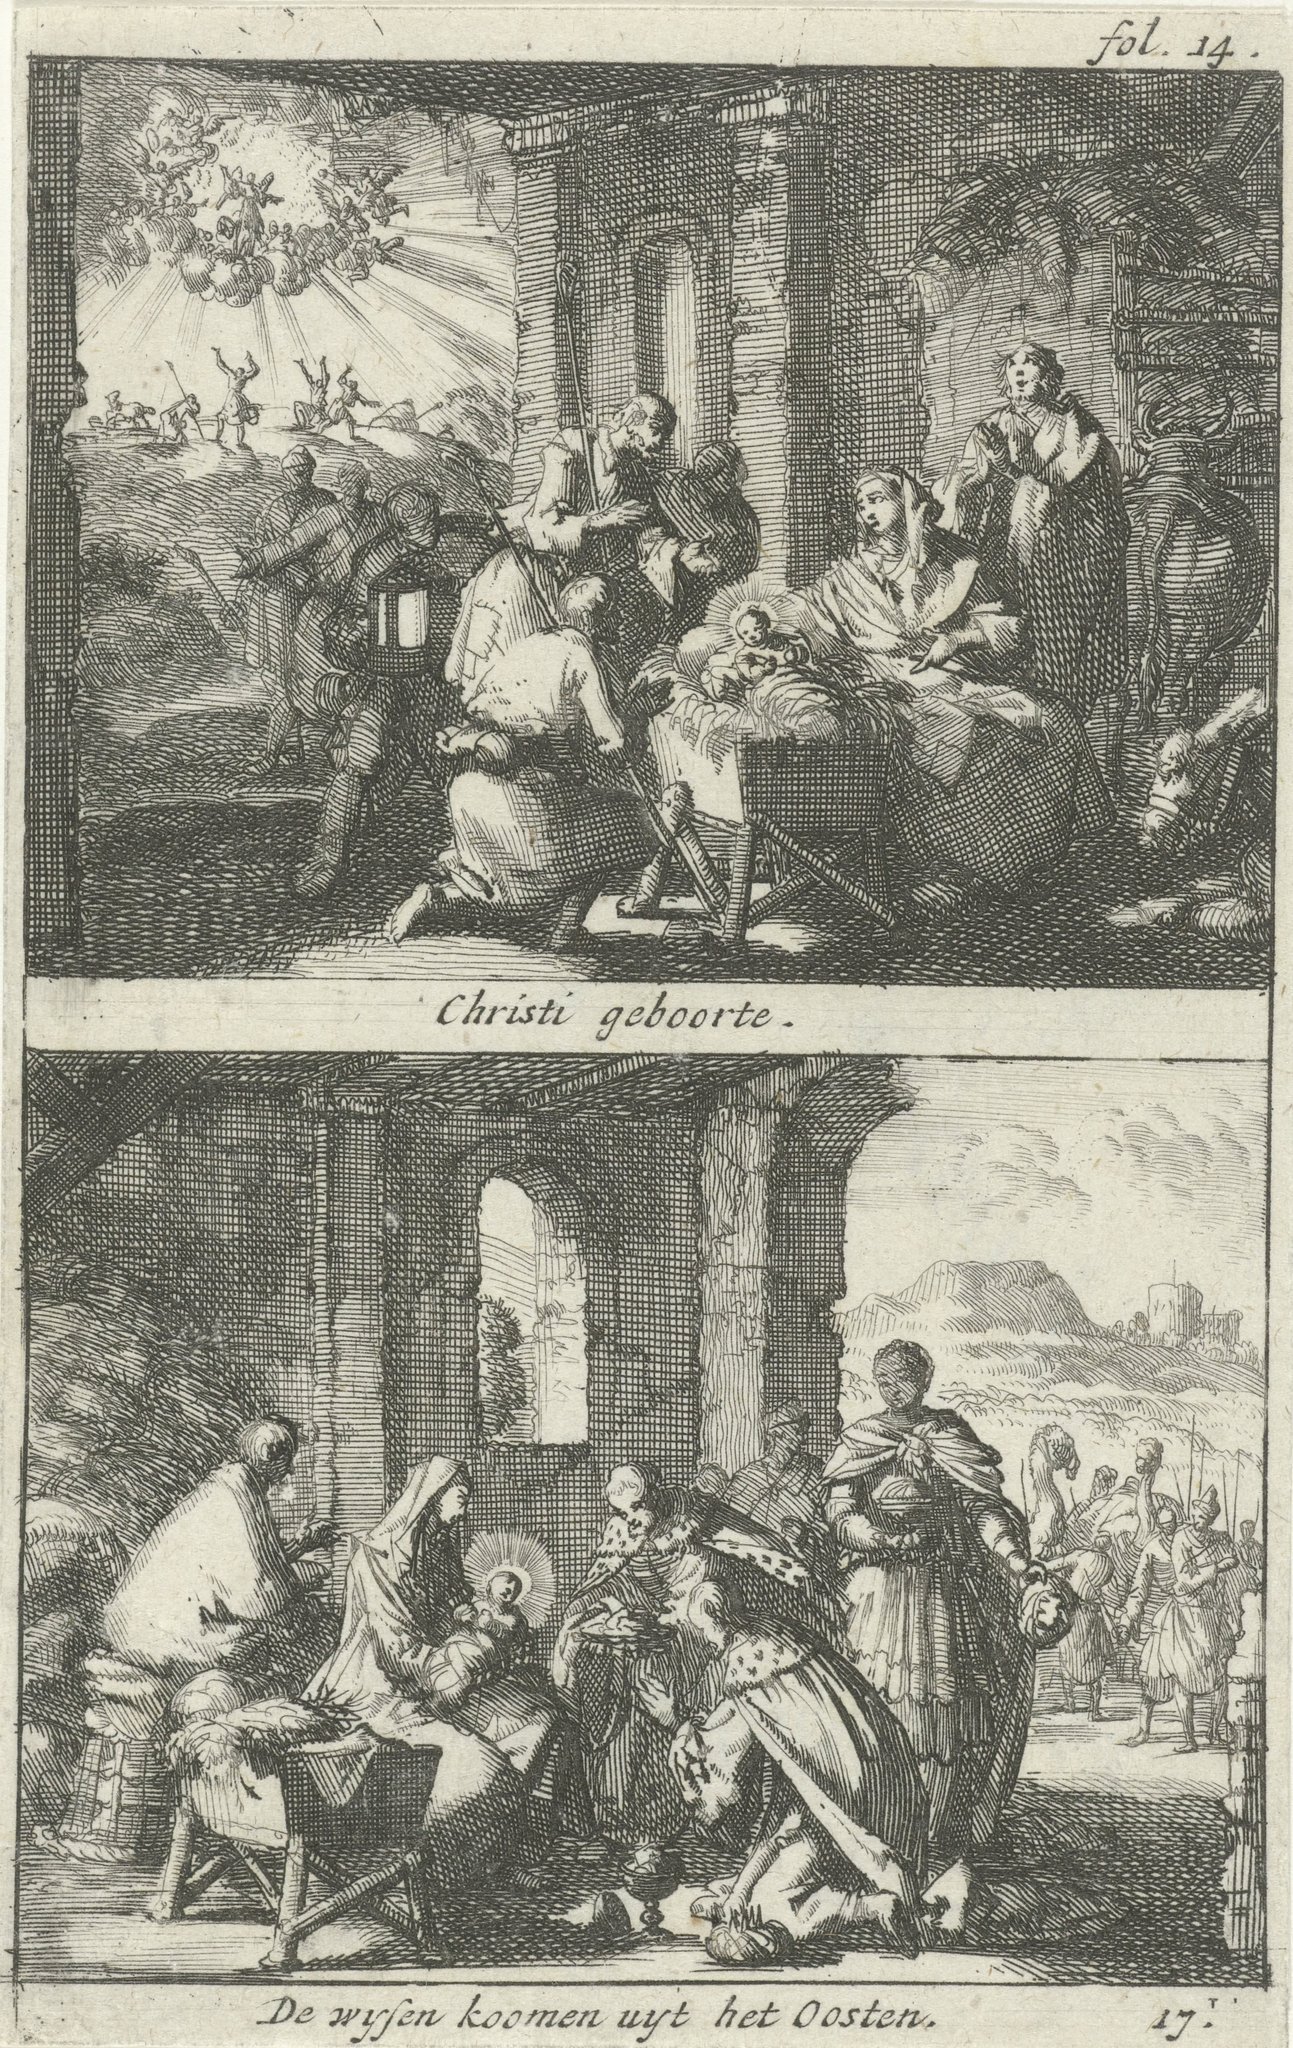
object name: book illustration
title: Geboorte van Christus en de aanbidding der koningen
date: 1690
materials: paper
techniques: etching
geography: amsterdam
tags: story of the birth of christ (luke 2:1-20), adoration of the kings: the wise men present their gifts to the christ-child (gold, frankincense and myrrh)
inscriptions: collector's mark: Lugt 2228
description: Illustratie uit: Garthwait, Henry. Historie des levens en stervens onses Heeren en saligmakers Jesu Christi. Amsterdam: Jan Claesz ten Hoorn, 1690.